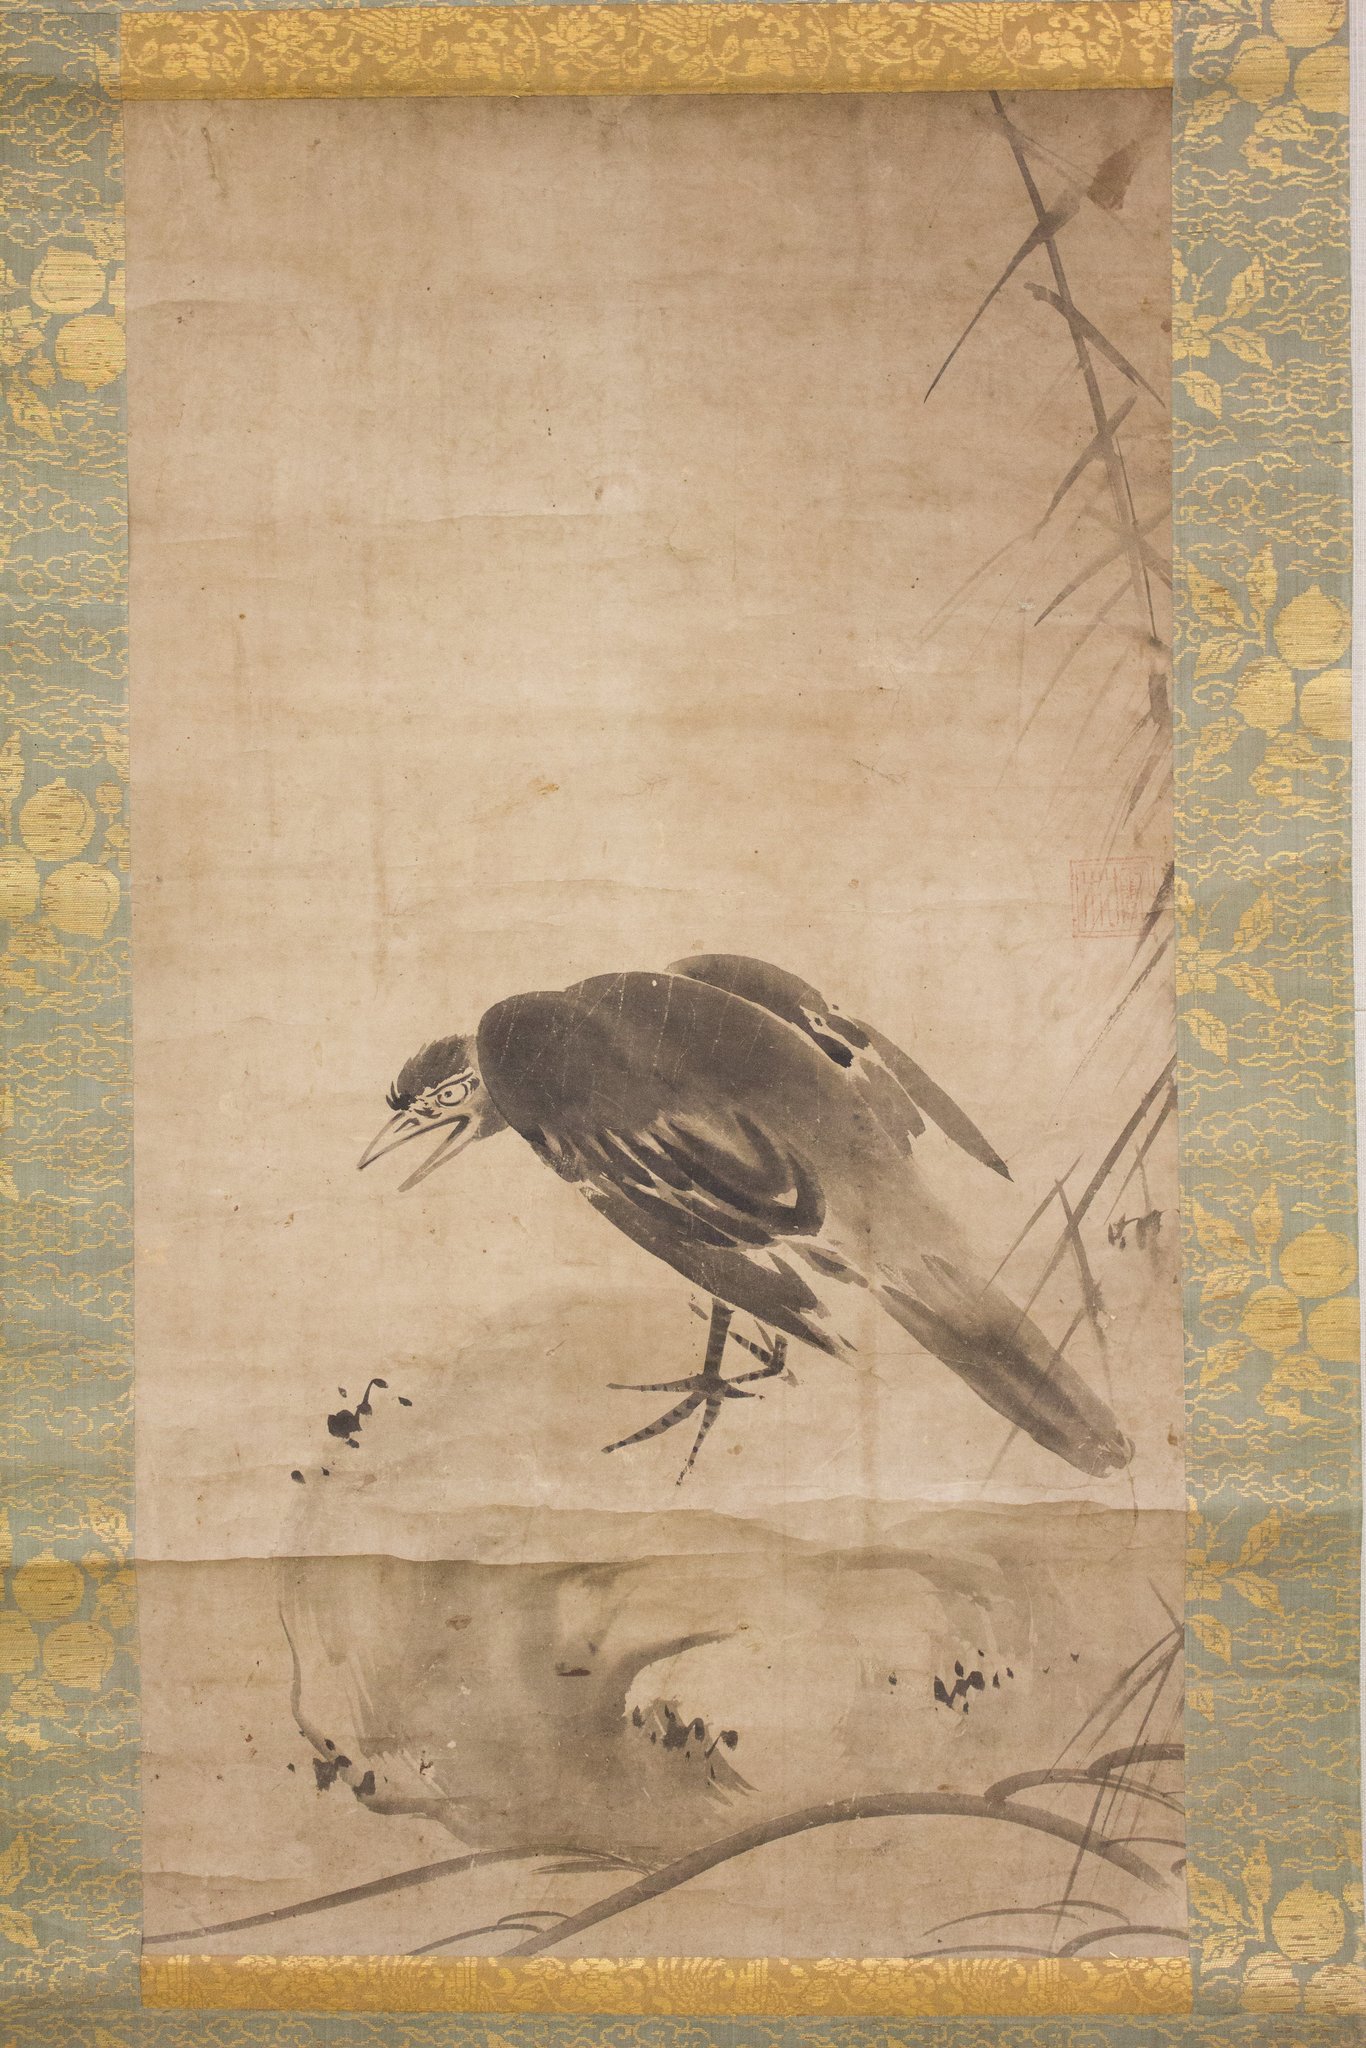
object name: hanging scroll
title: Crow on a Rock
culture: japanese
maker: sesson shūkei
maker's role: artist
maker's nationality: japanese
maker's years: 1504-1589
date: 1801-1900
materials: ink, paper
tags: birds